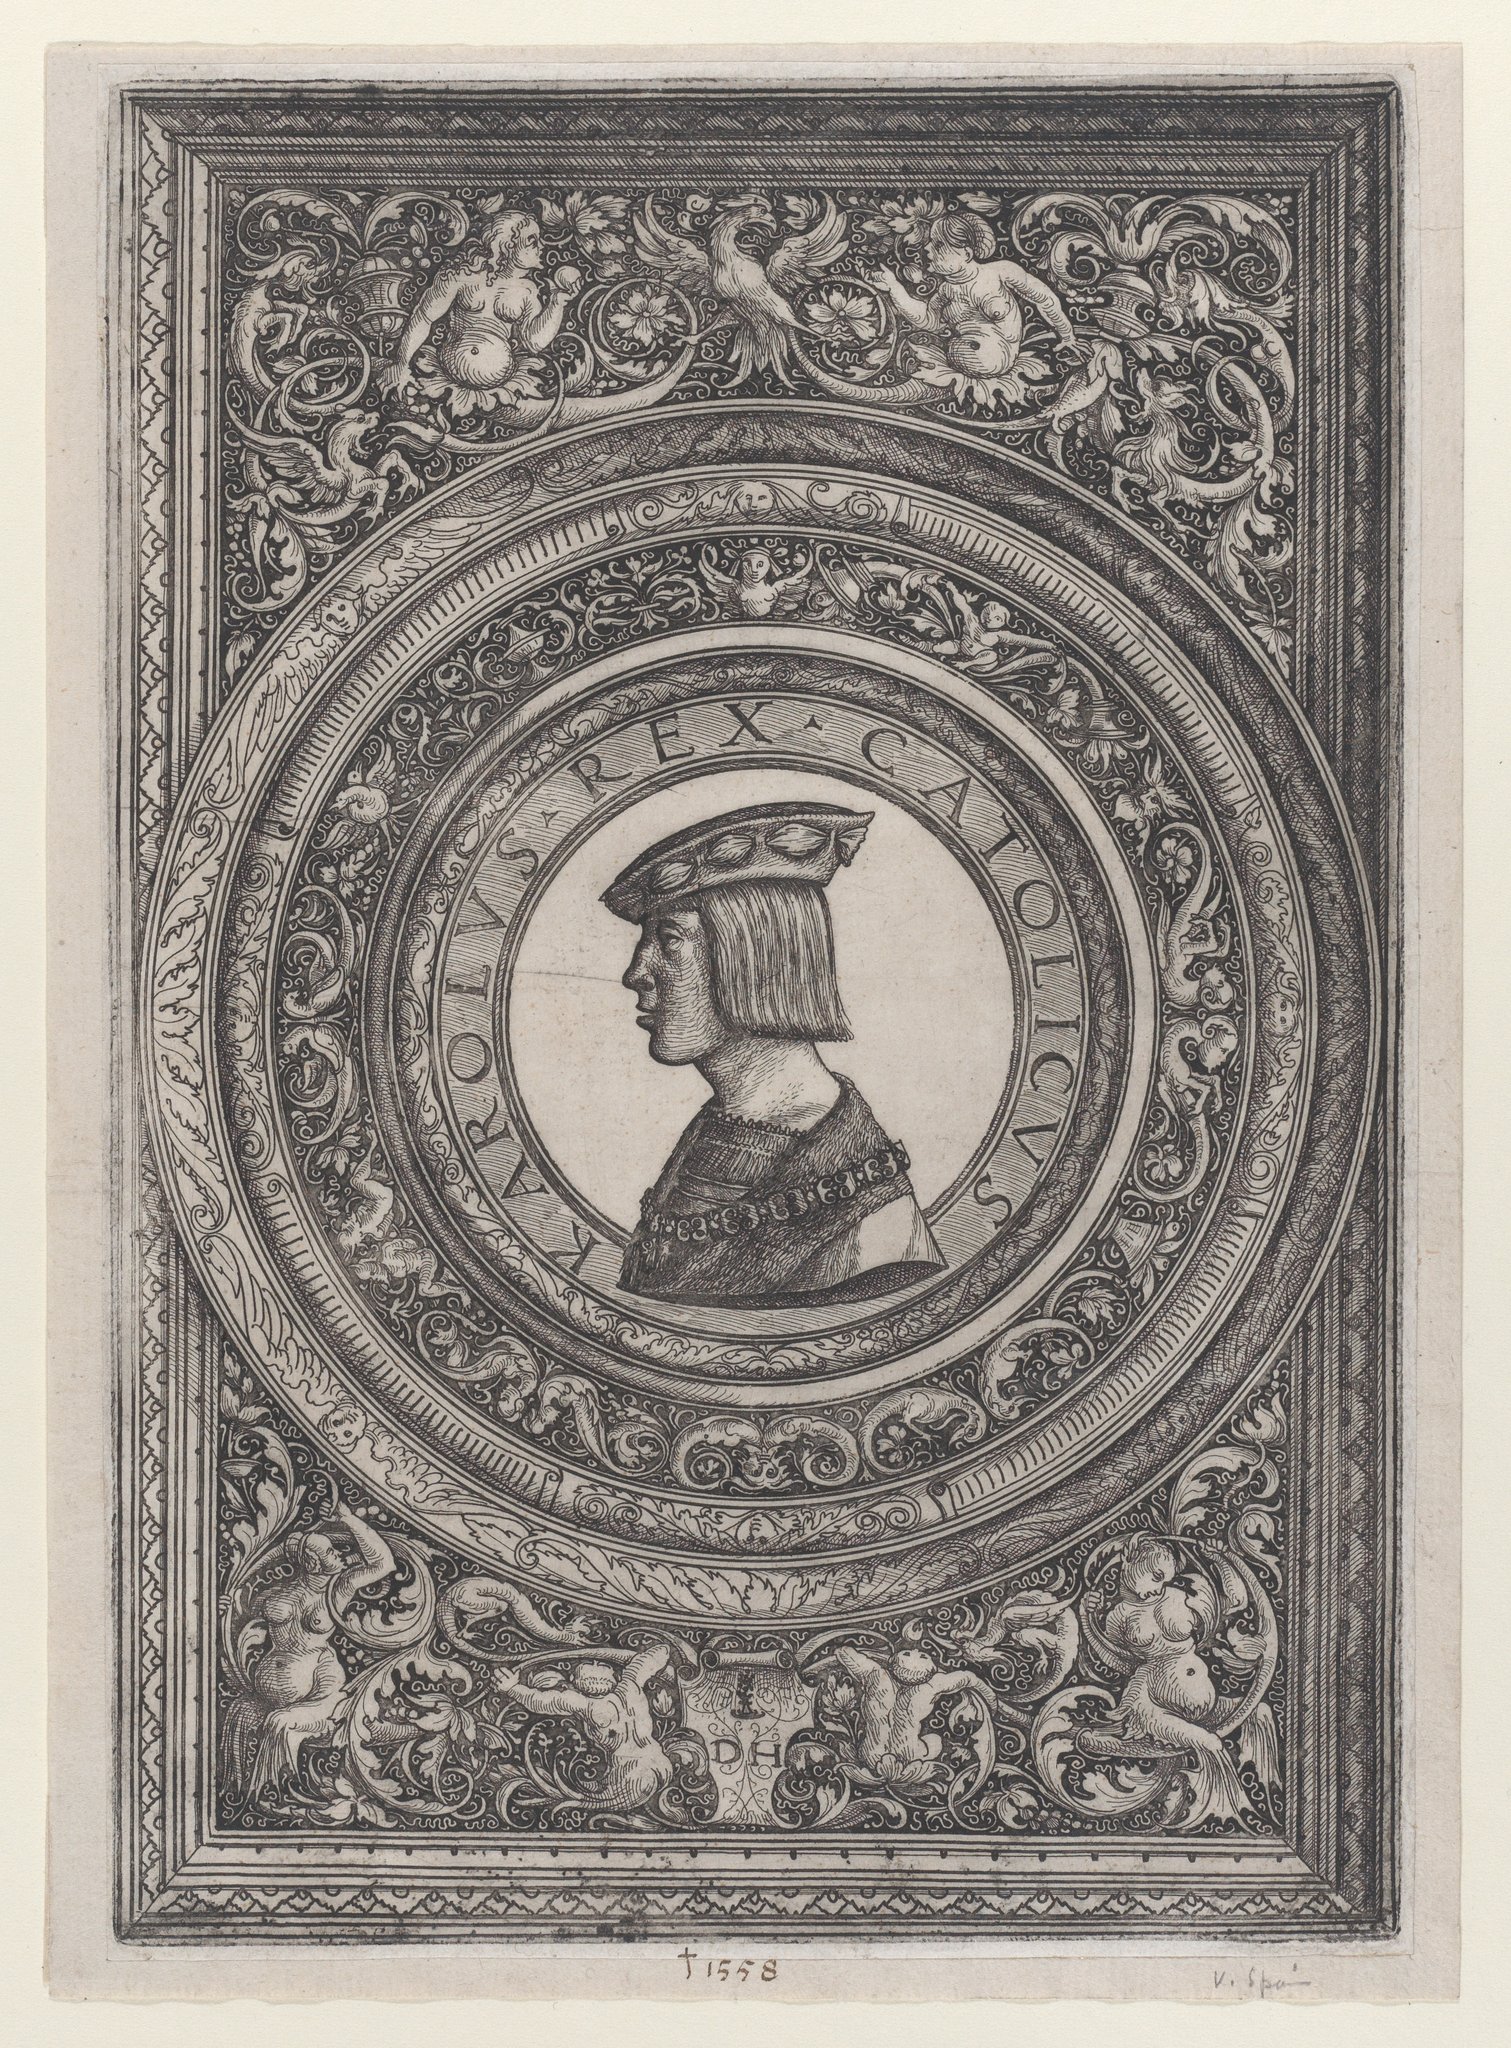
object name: print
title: Portrait of Emperor Charles V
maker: daniel hopfer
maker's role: artist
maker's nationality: german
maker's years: 1470-1536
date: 1519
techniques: etching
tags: birds,men,profiles